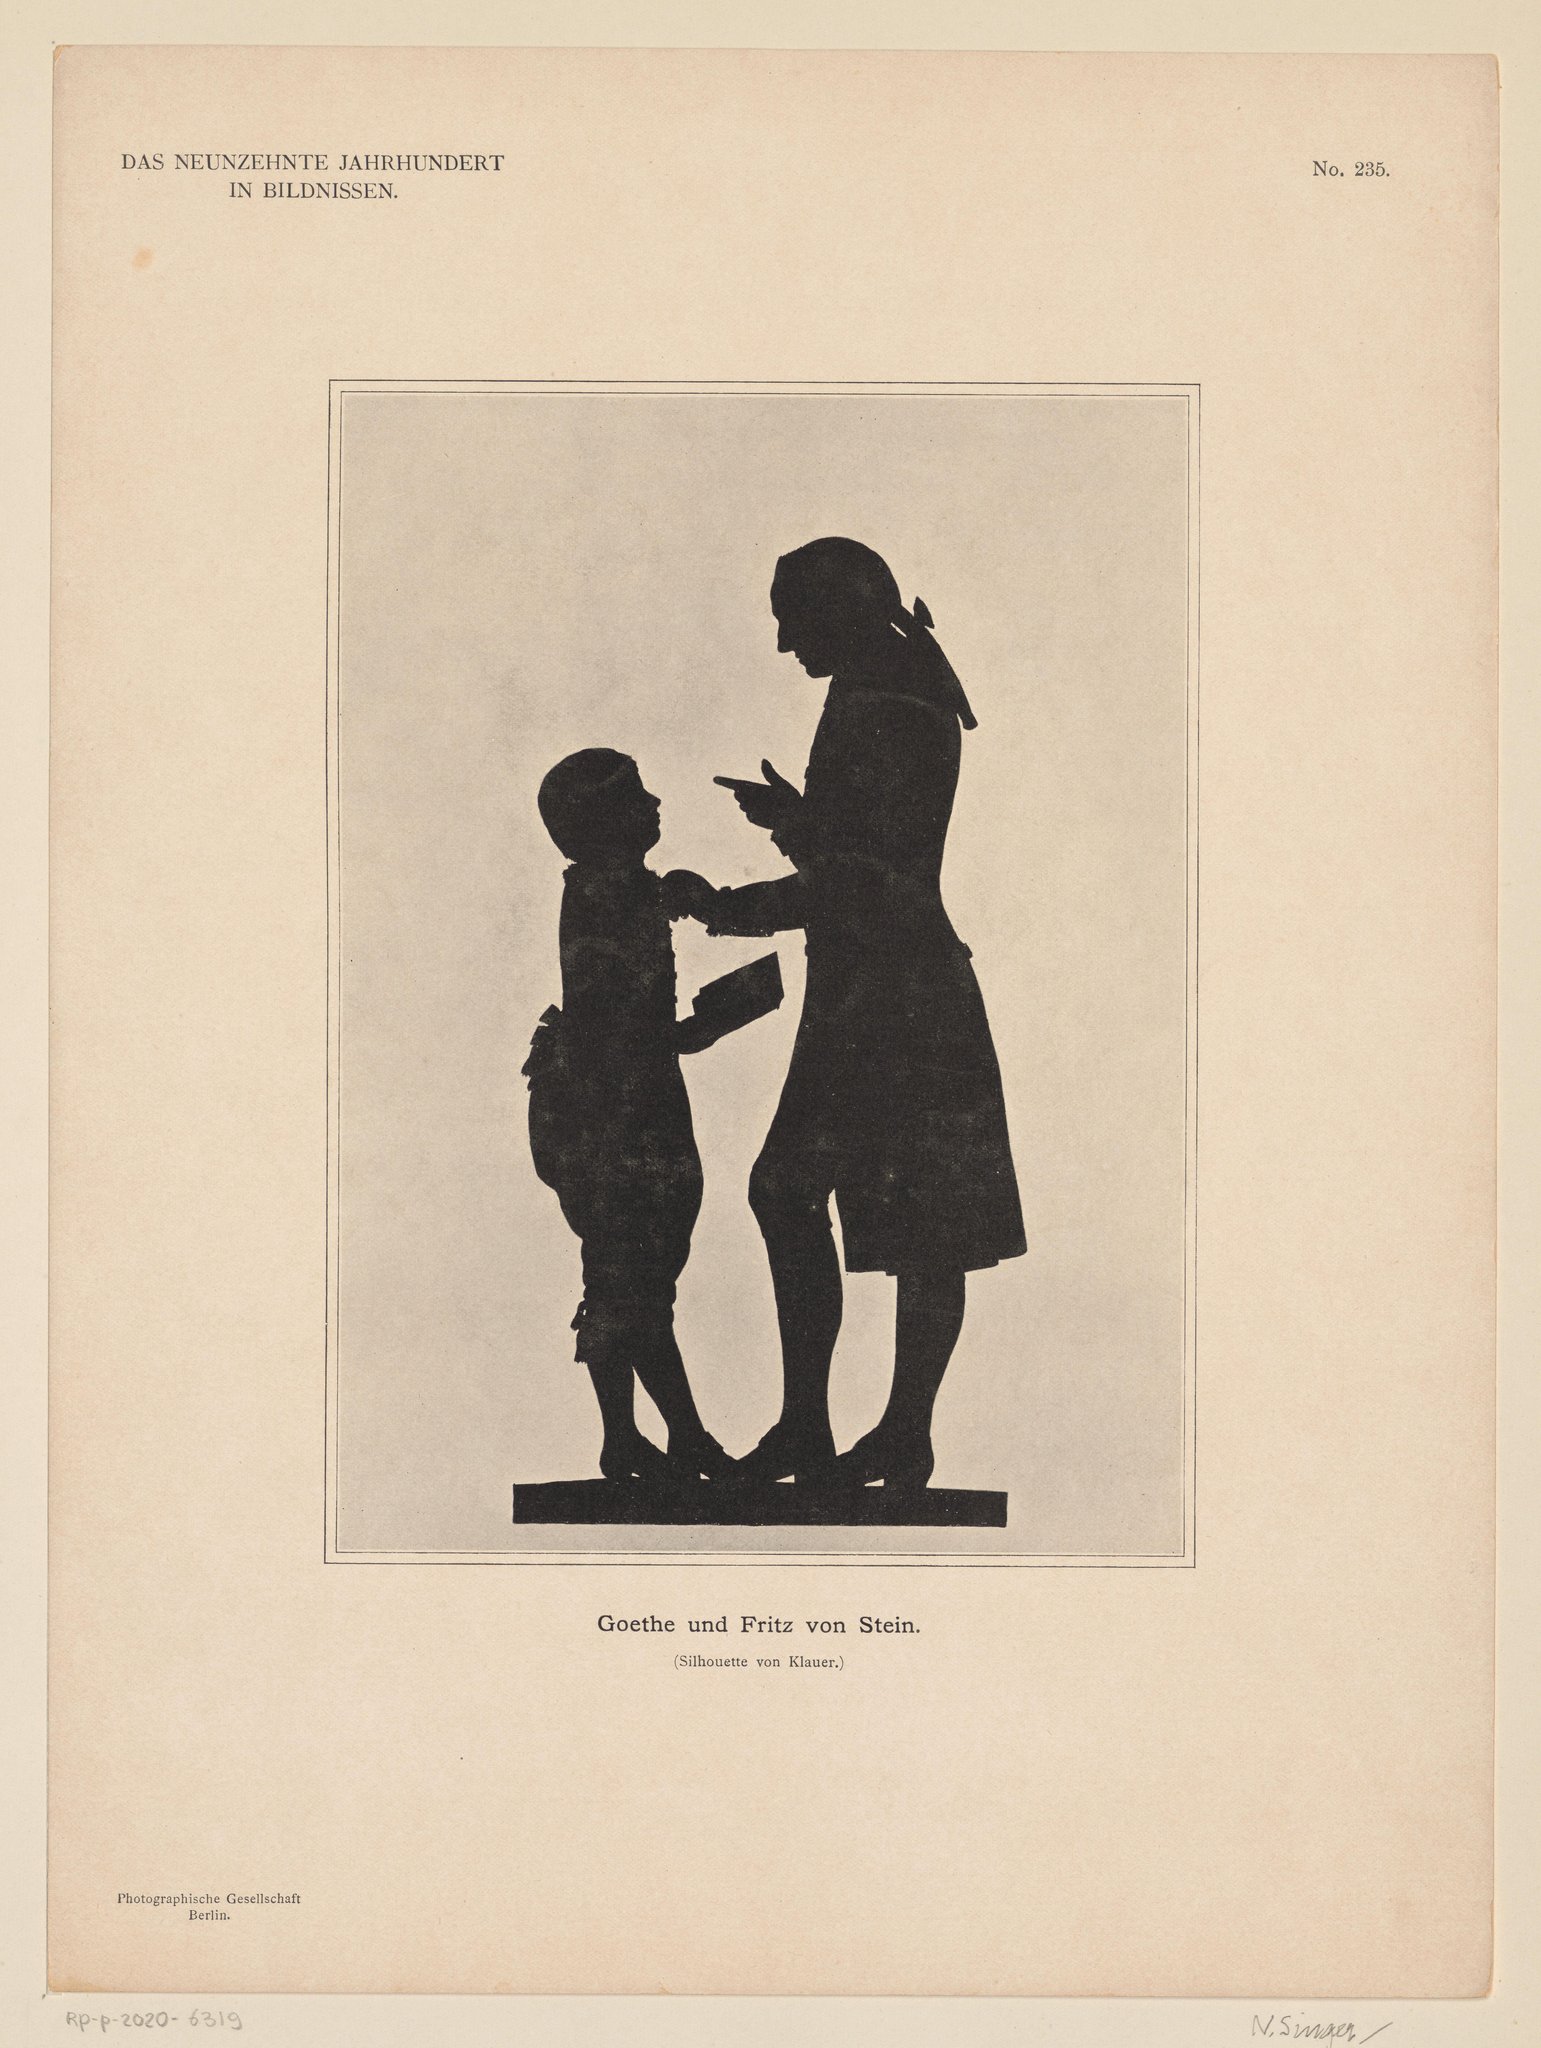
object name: photomechanical print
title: Silhouetportret van Johann Wolfgang von Goethe met Fritz von Stein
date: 1899-1901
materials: paper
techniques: letterpress printing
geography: berlin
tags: draughtsman, johann wolfgang von goethe, historical persons, portrait of a writer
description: Prent waarschijnlijk uit: Werkmeister, Karl. Das Neunzehnte jahrhundert in Bildnissen. 4 dln. Berlijn: Photographischen Gesellschaft, [1899-1901].